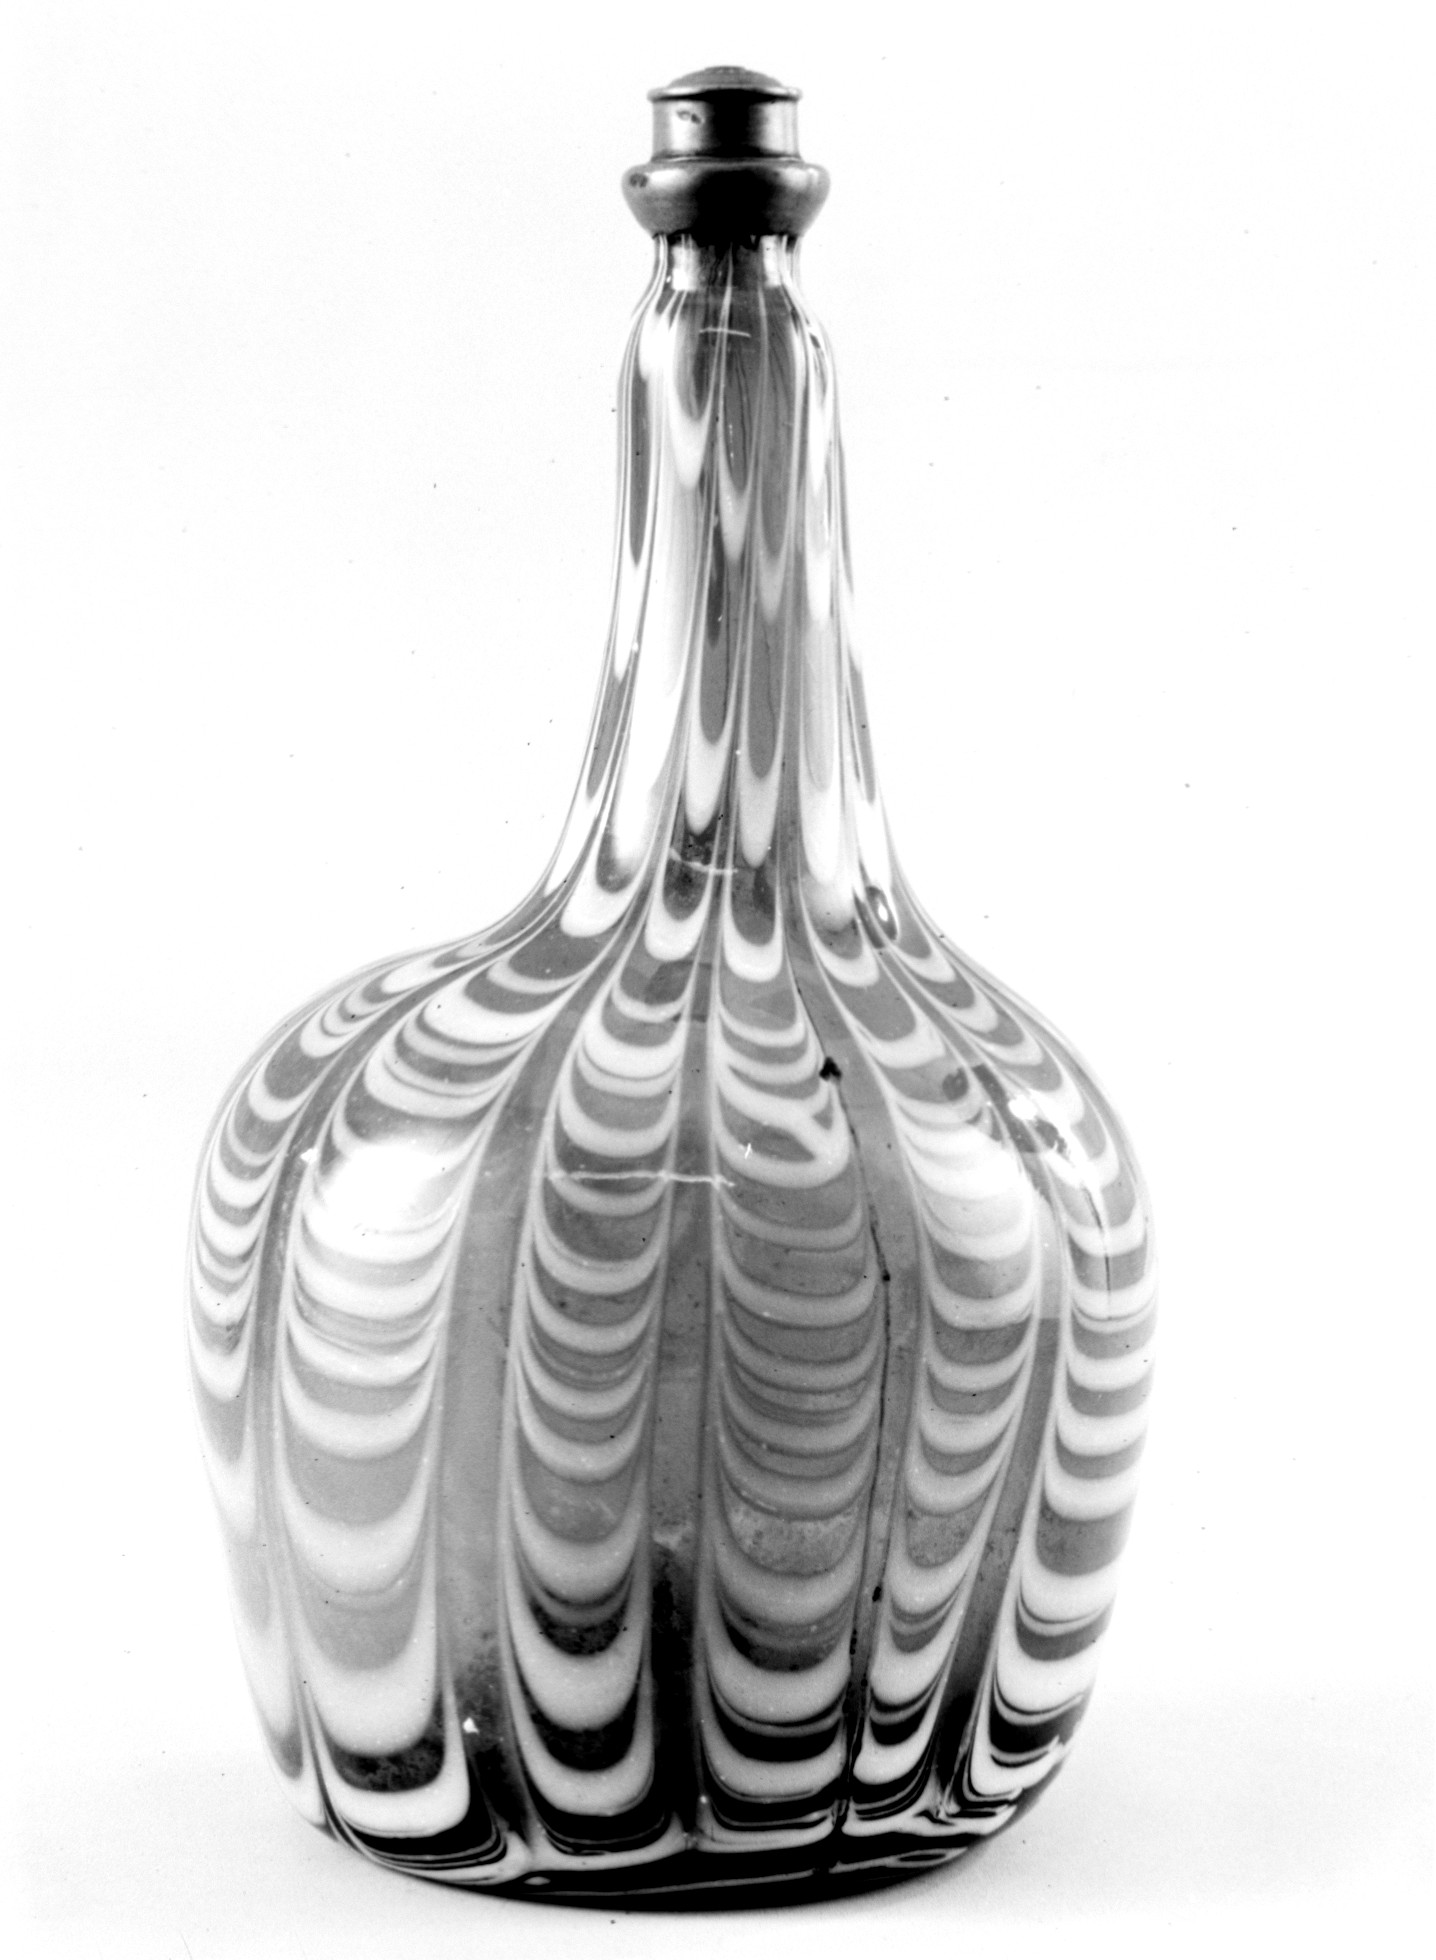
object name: bottle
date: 1601-1800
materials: glass, pewter